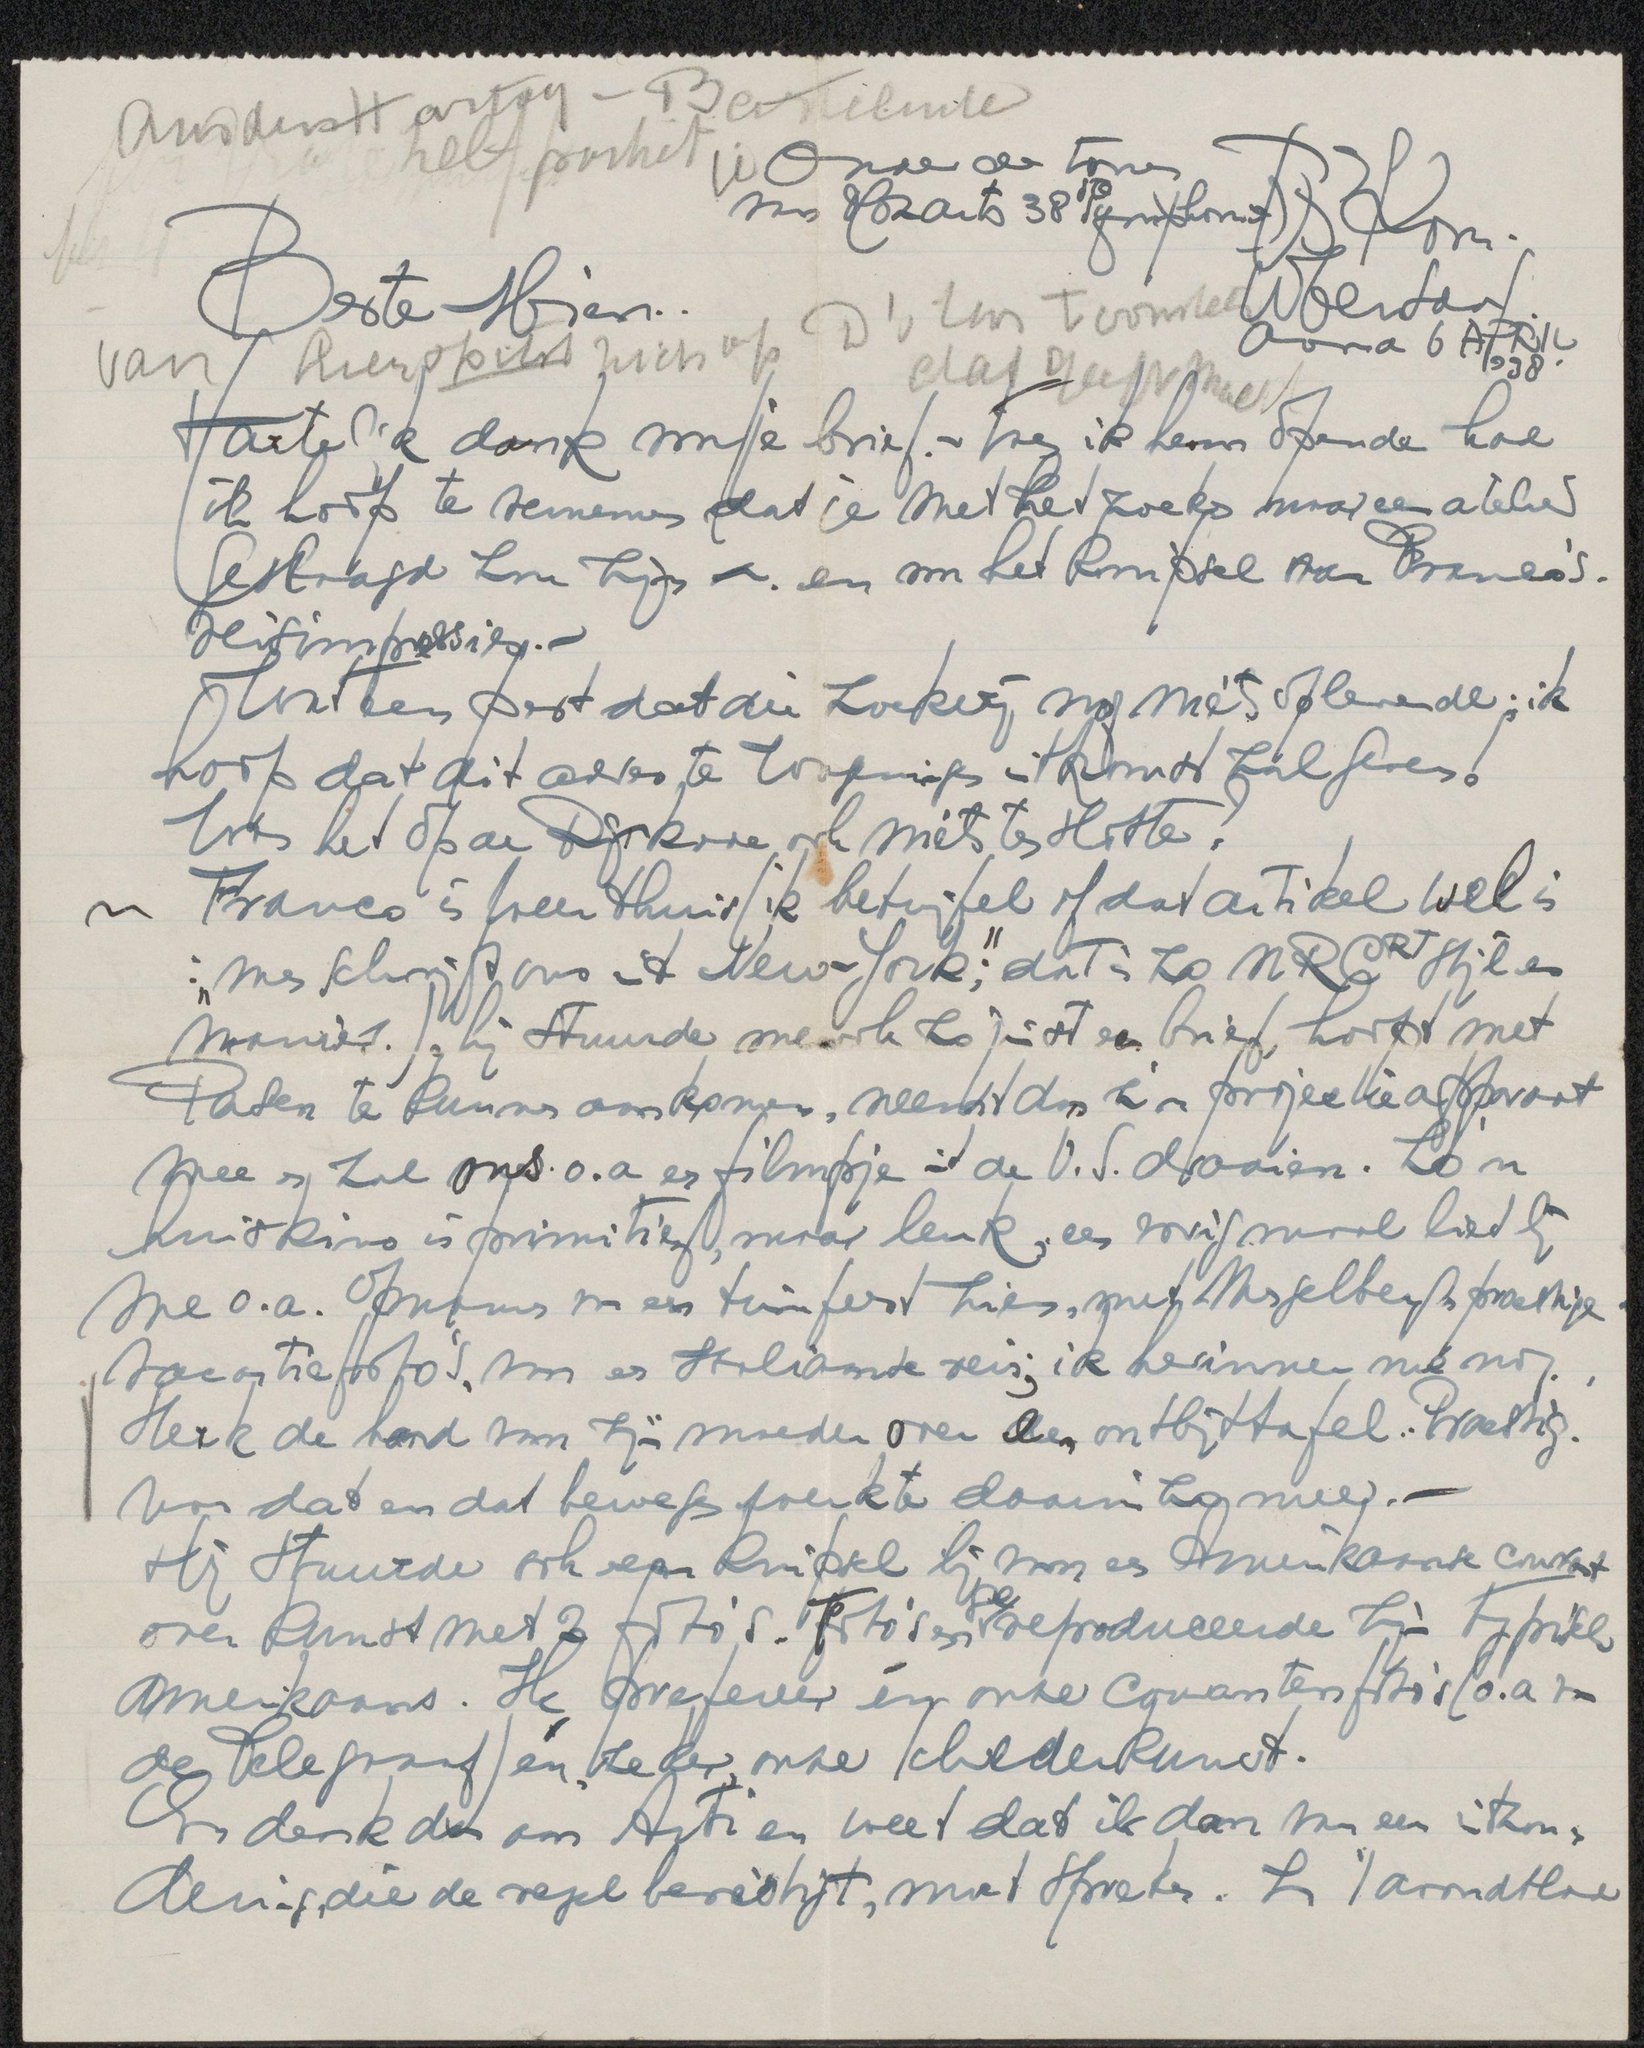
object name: letter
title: Brief aan Mien Cambier van Nooten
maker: dick ket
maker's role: draughtsman, print maker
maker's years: 1902-1940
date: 1938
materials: ink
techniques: pen, writing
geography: bennekom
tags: grave, arnhem, mien cambier van nooten, passions, emotions, affections, painting (including book-illumination, miniature-painting), workshop, studio of the artist (in general), historical persons (portraits and scenes from the life)